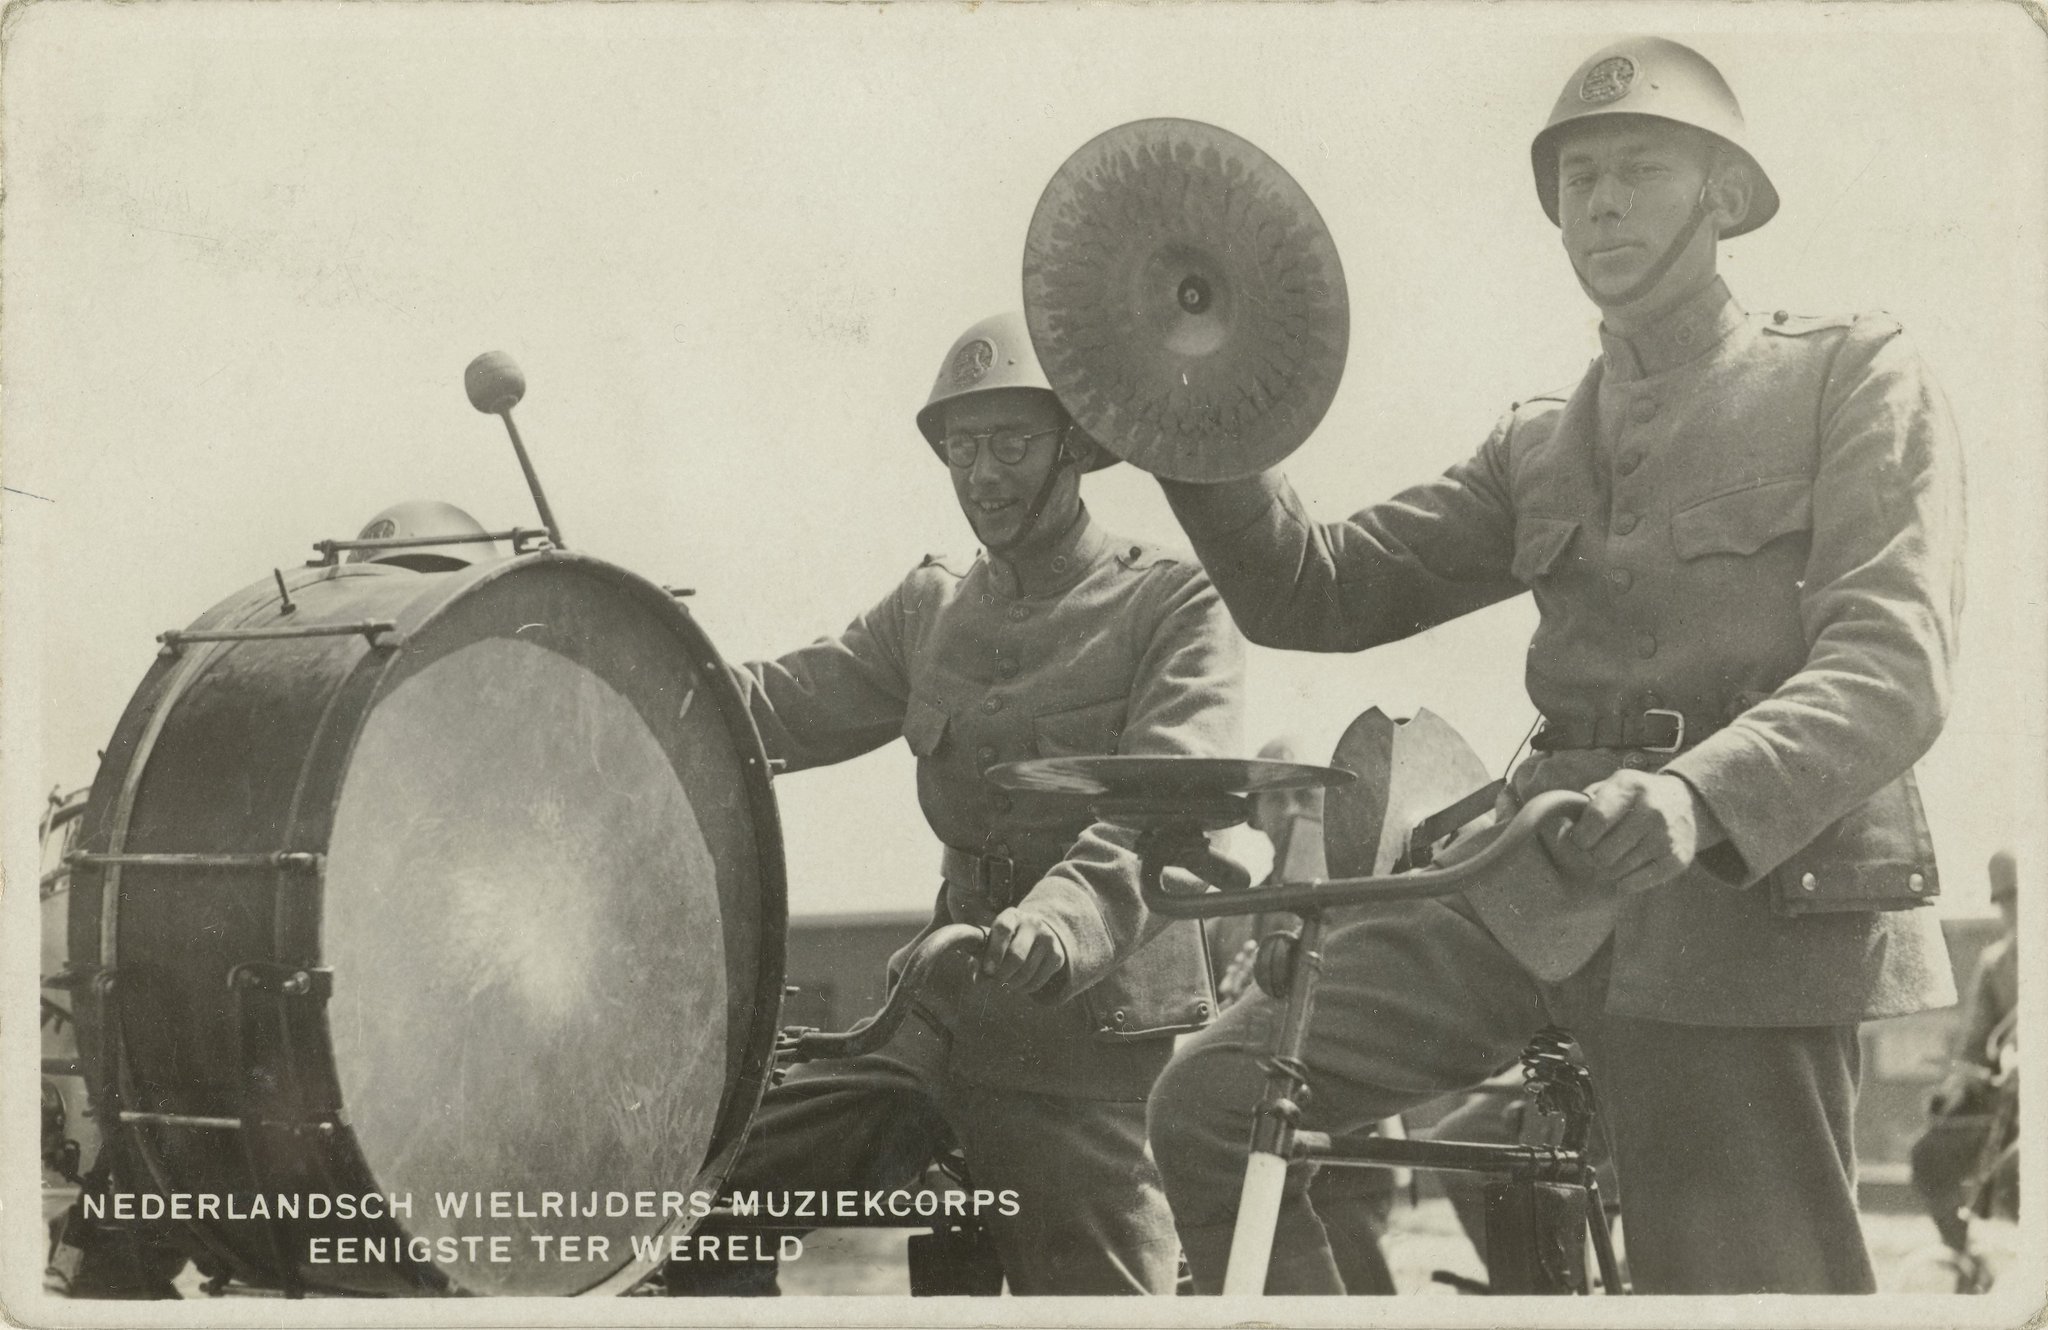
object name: photograph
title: Militair muziekcorps op de fiets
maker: Anonymous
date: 1925-1935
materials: photographic support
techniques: gelatin silver print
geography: netherlands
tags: musical instruments; group of musical instruments, making music; musician with instrument, bicycle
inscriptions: name: ‘Uitg. KEllerman Rotterdam’